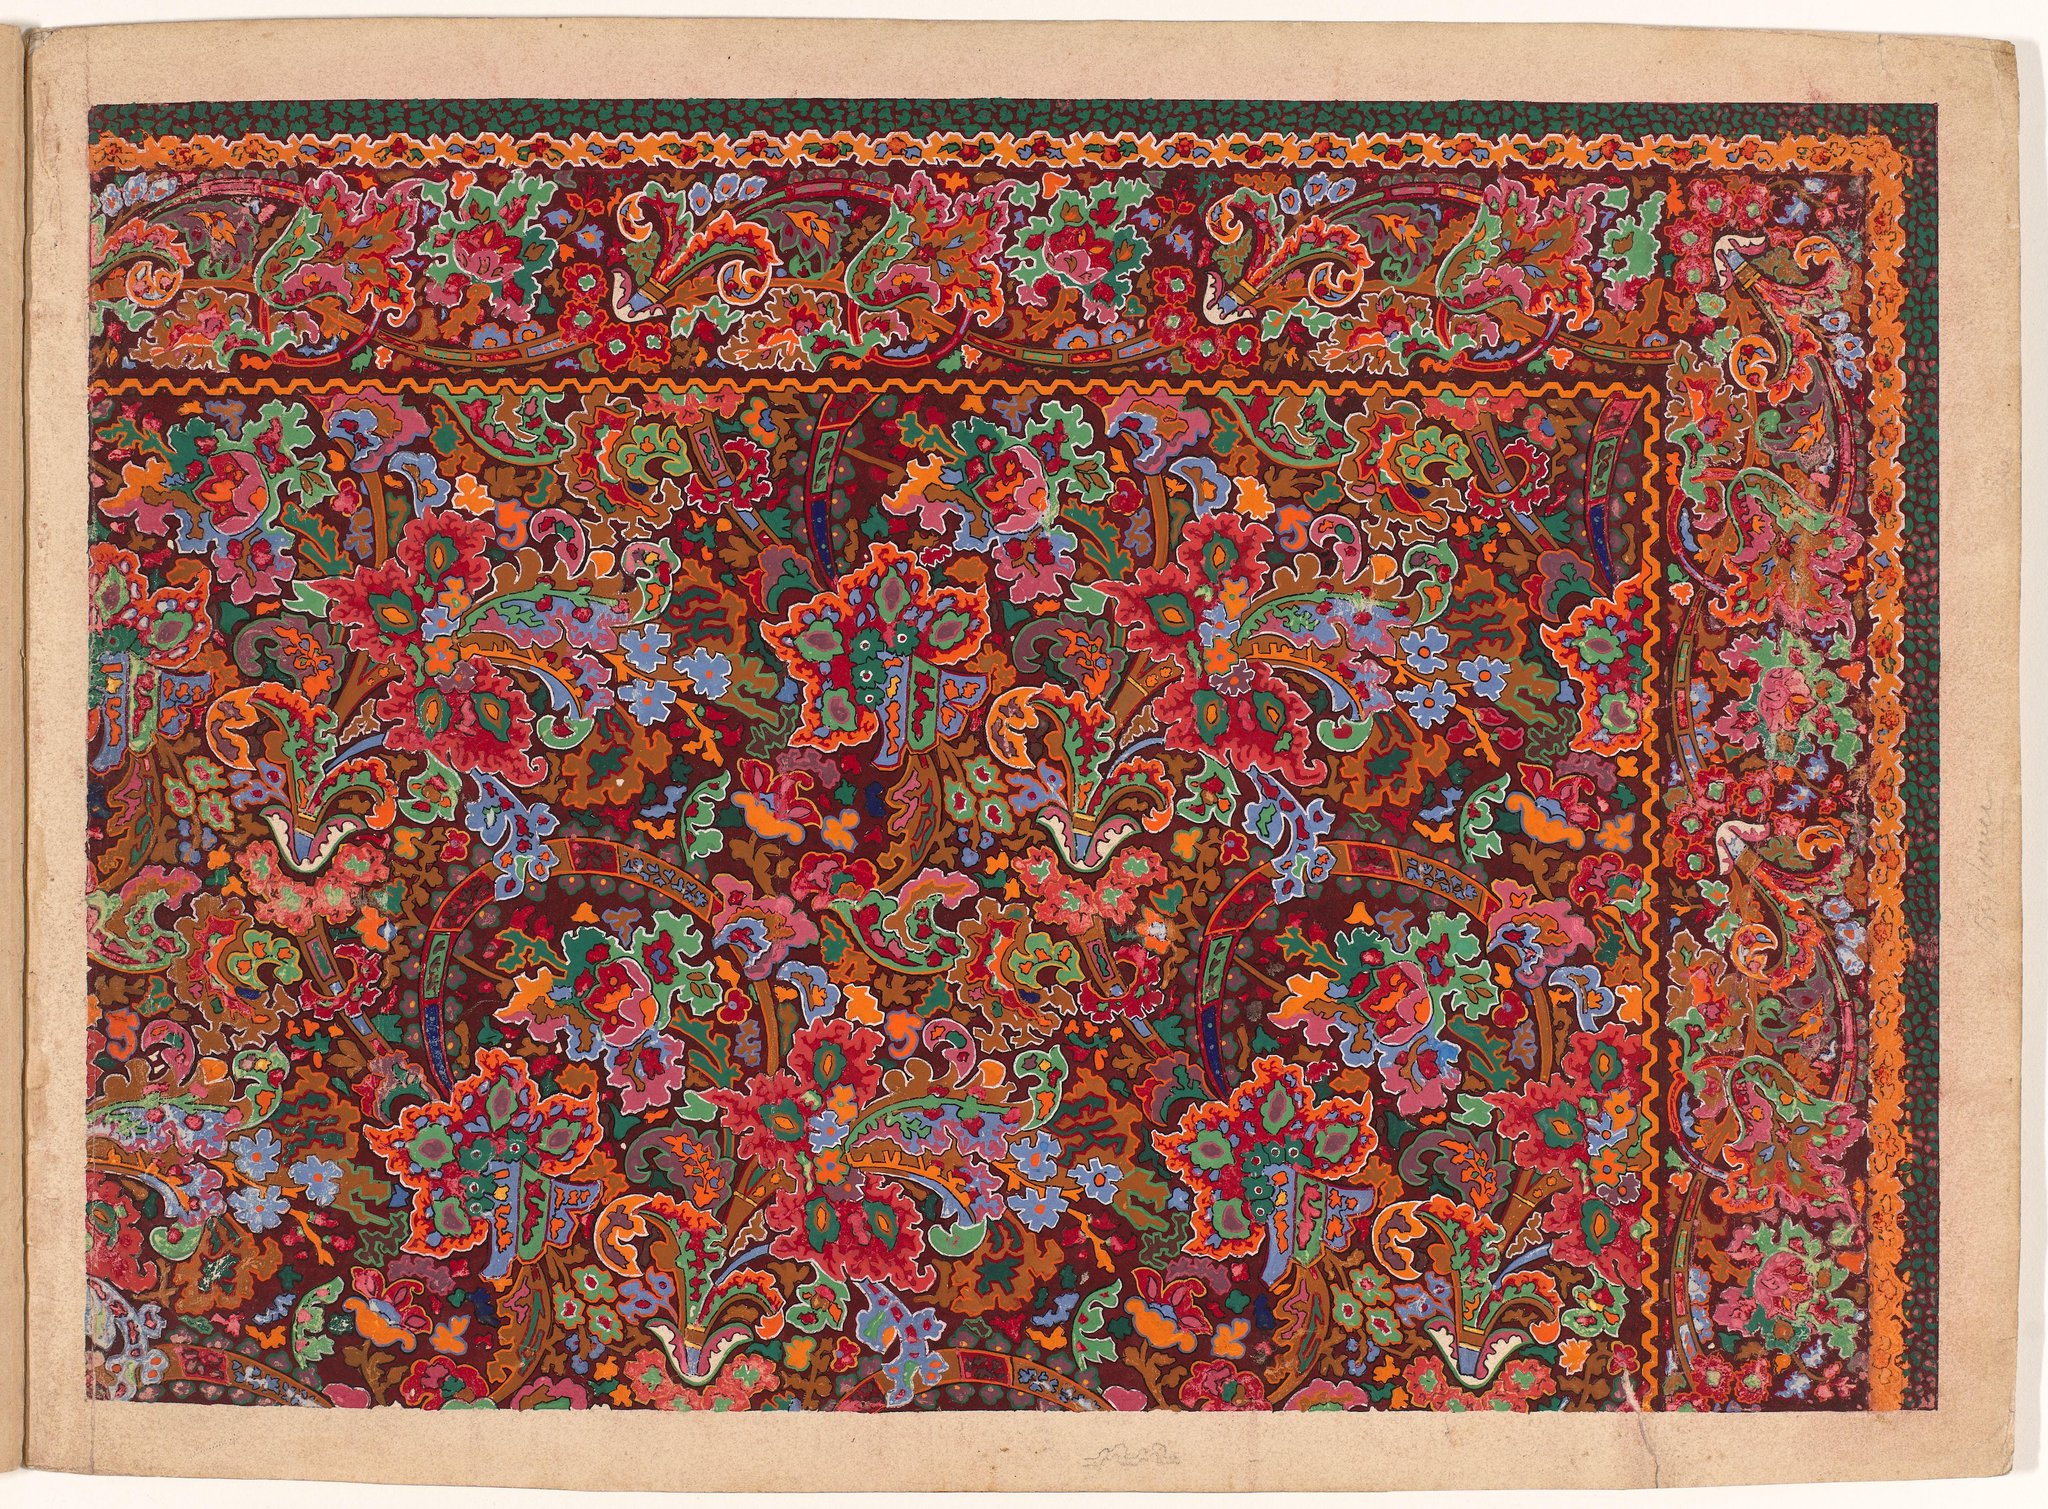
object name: drawing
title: Ontwerp voor een tapijt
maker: Anonymous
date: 1854-1864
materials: gouache, paper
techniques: brush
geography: deventer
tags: ornaments ~ art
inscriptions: number: ‘No 360 A.’, inscription: ‘Deze teekenin kan niet in 2 qualiteit gemaakt worden.’, retailer's mark: ‘JHS.’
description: De presentatietekeningen BK-1971-77-1 t/m 86 zijn kopieën van de originele ontwerptekeningen. Ze werden gemaakt voor vertegenwoordigers van bijvoorbeeld magazijnen, die ze aan hun klanten konden tonen. De meeste tekeningen tonen een kwart van het dessin inclusief rand, middenpartij (de zogenaamde grond of fond) en centraal medaillon. Door het gebruik van spiegels kan de illusie van het gehele tapijt worden opgeroepen. Een deel van de tekeningen heeft een alfabetische opeenvolgende letter als kenmerk, de andere groep een cijfer.Waarschijnlijk is de reeks dessins met een letter eerder samengesteld dan de genummerde tekeningen.